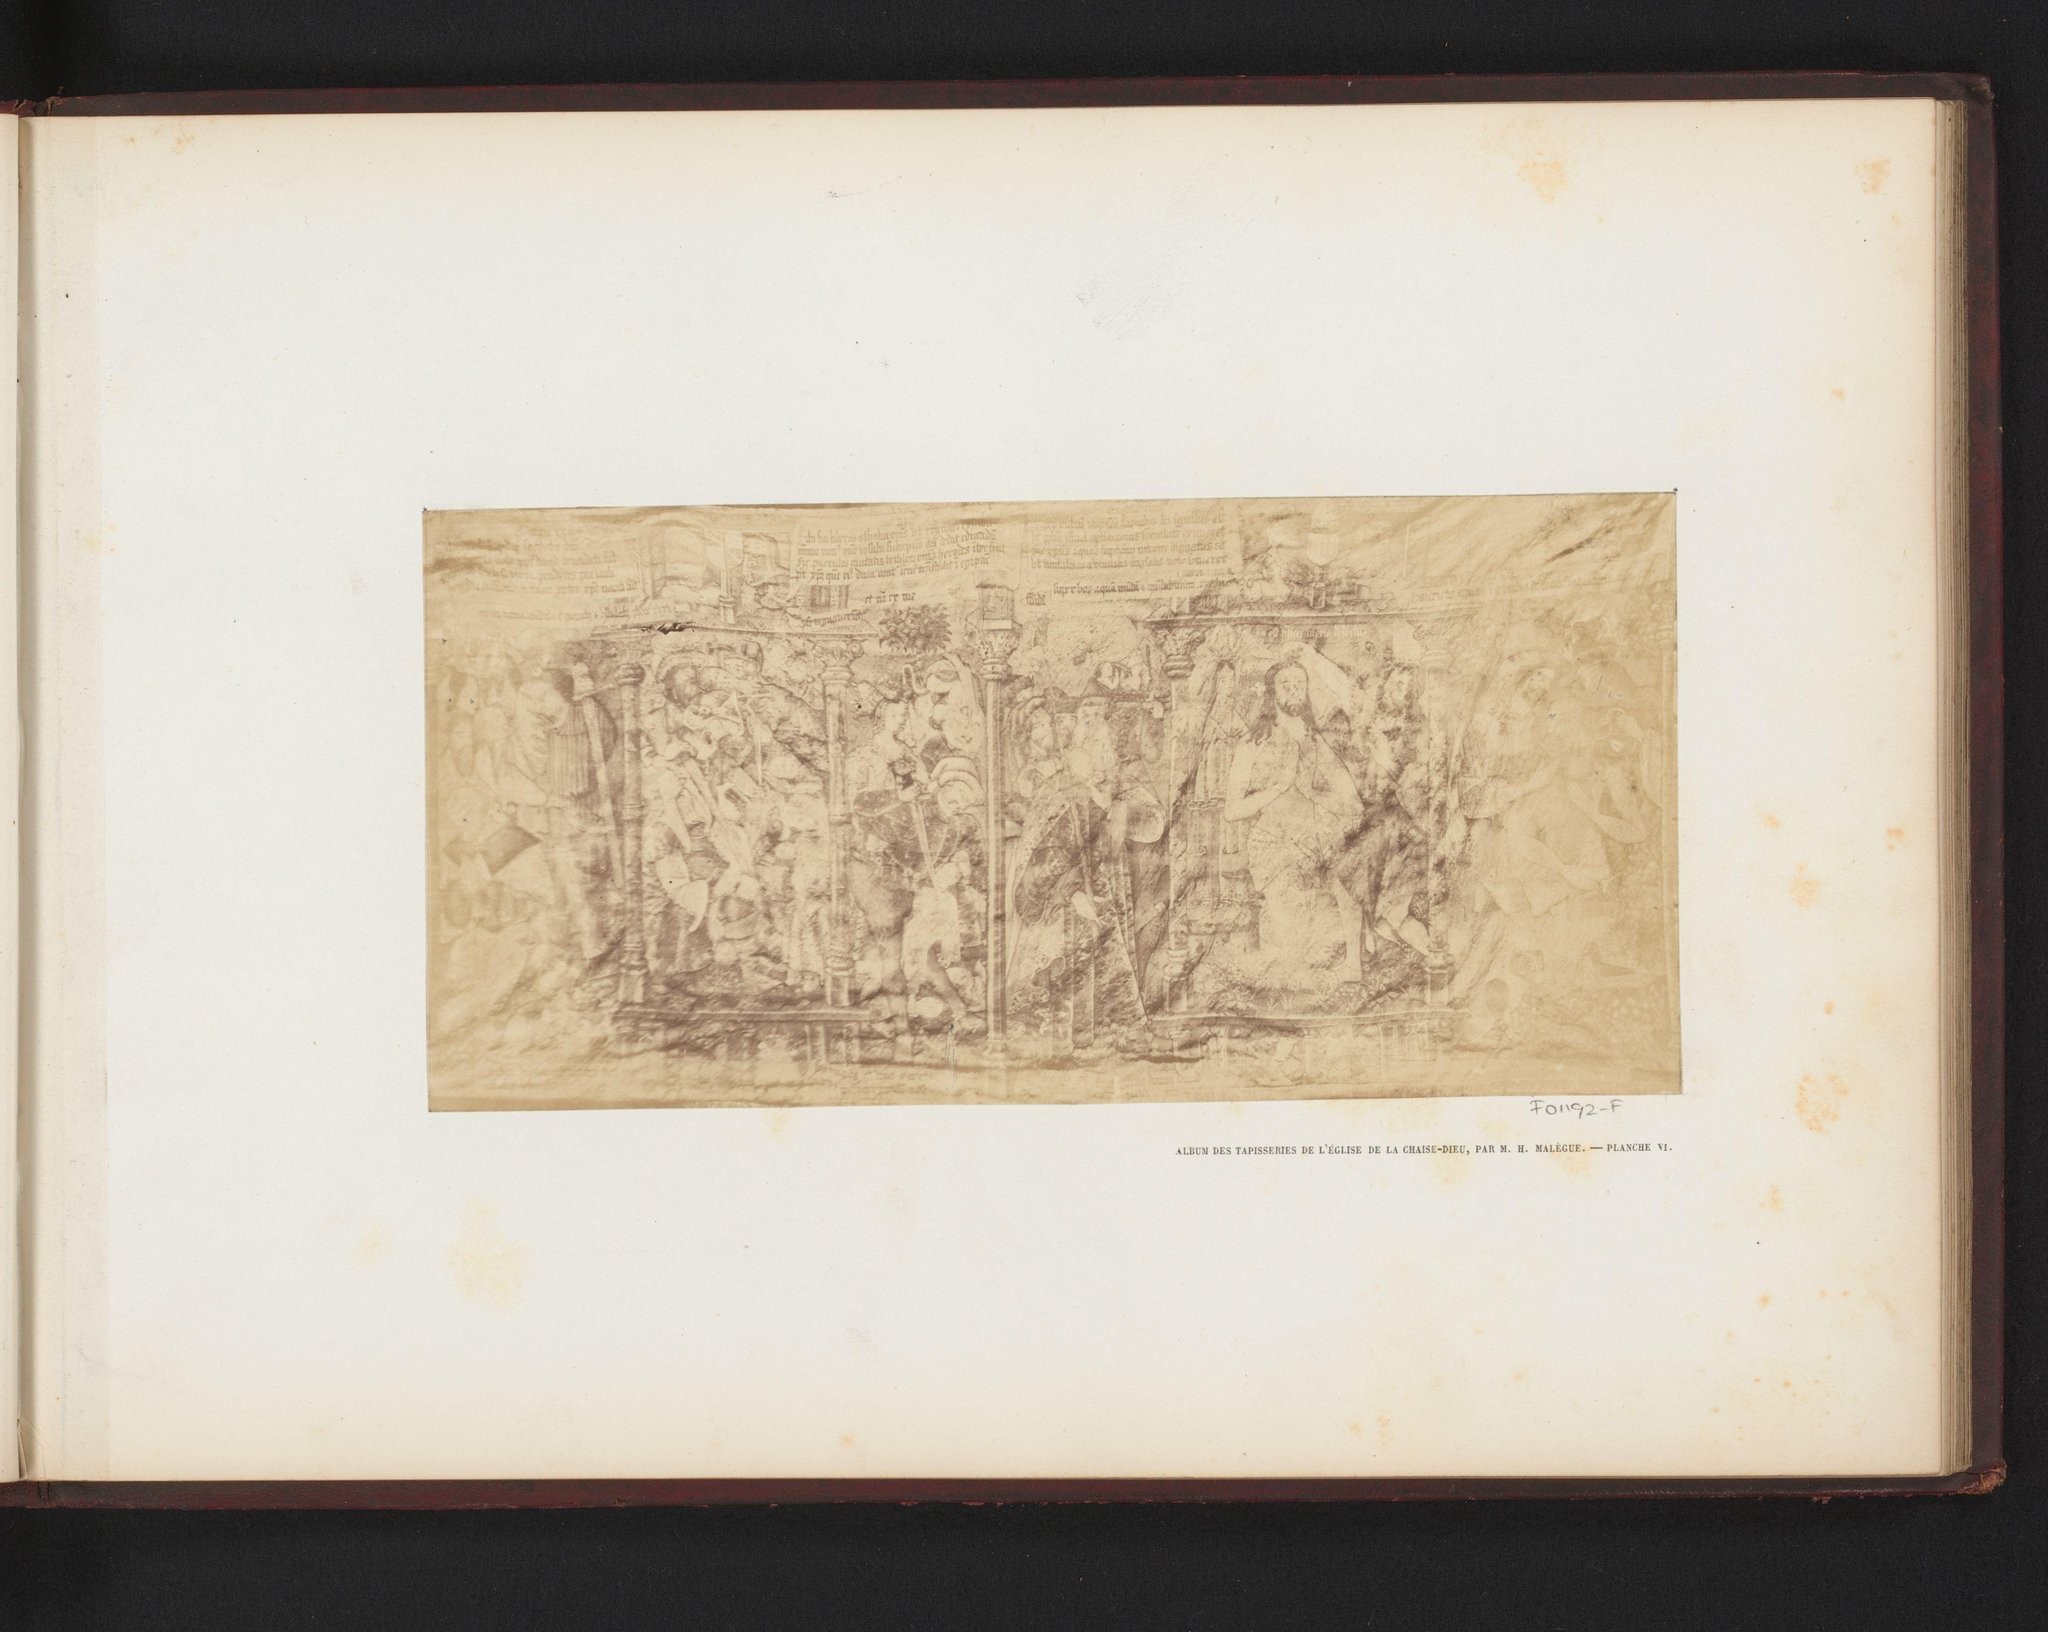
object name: page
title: Tapijt met de doop van Christus en prefiguraties in een kerk te La Chaise-Dieu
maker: hippolyte malègue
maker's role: archeoloog, fotograaf, schrijver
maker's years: 1825-1901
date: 1868-1873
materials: photographic support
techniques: albumen print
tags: tapestry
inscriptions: inscription: ‘album des tapisseries de l'église de la Chaise-Dieu, par M. H. Malegue - Planche VI’